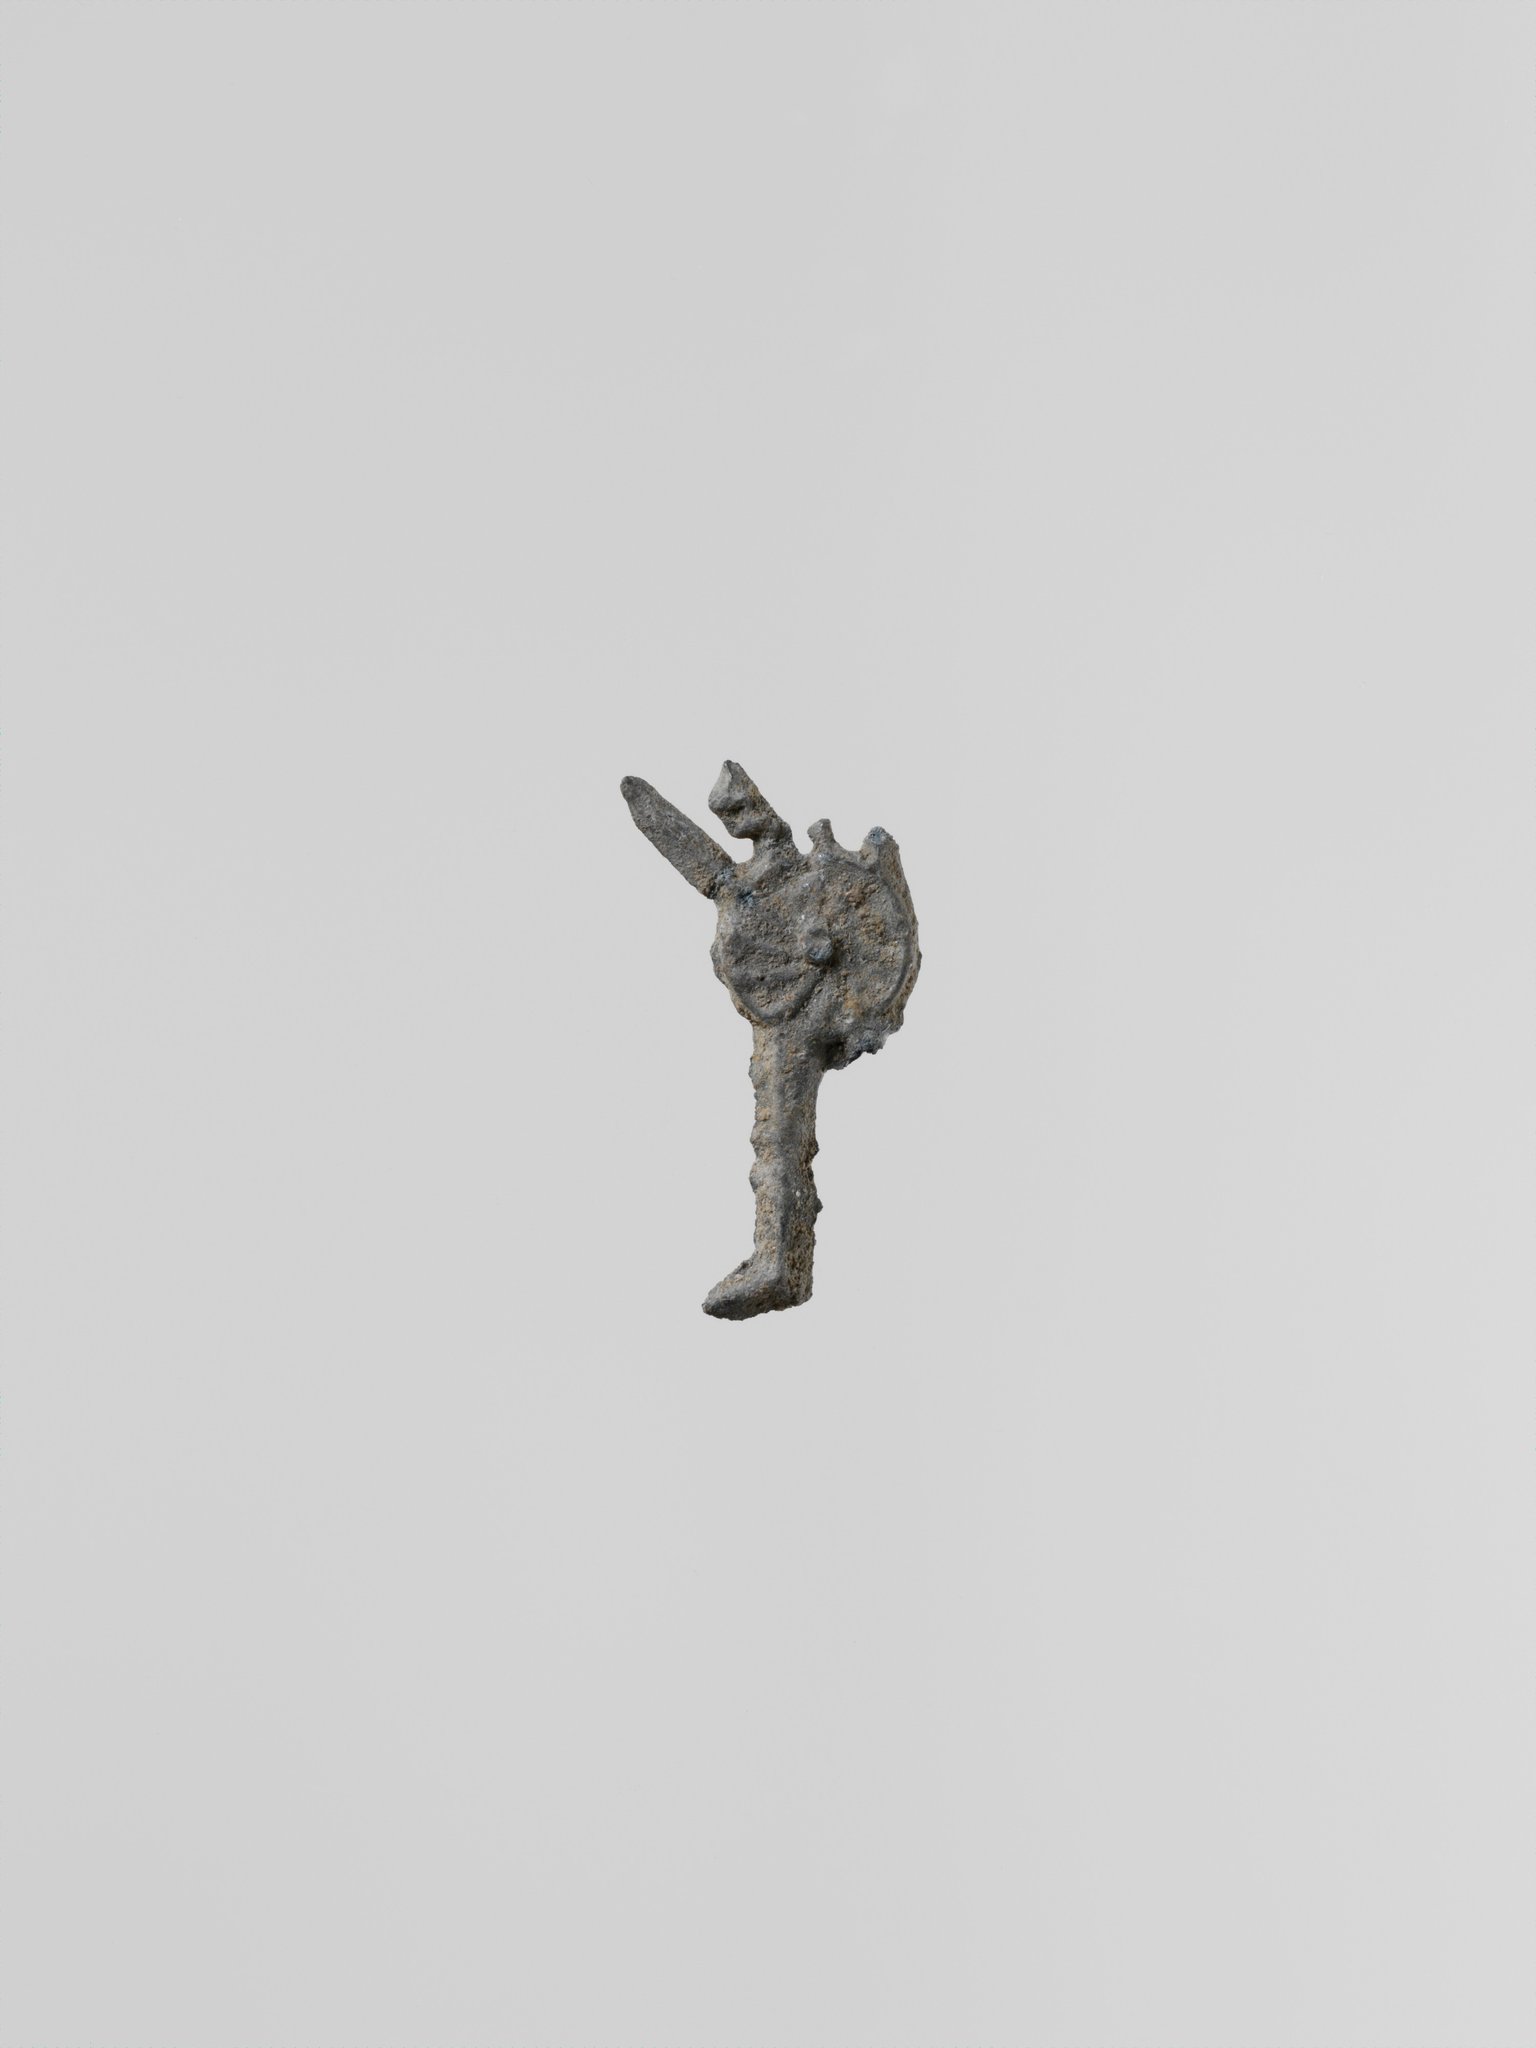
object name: statuette of a warrior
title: Statuette of a warrior-11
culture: greek, laconian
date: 7000-30 BCE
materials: lead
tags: human figures